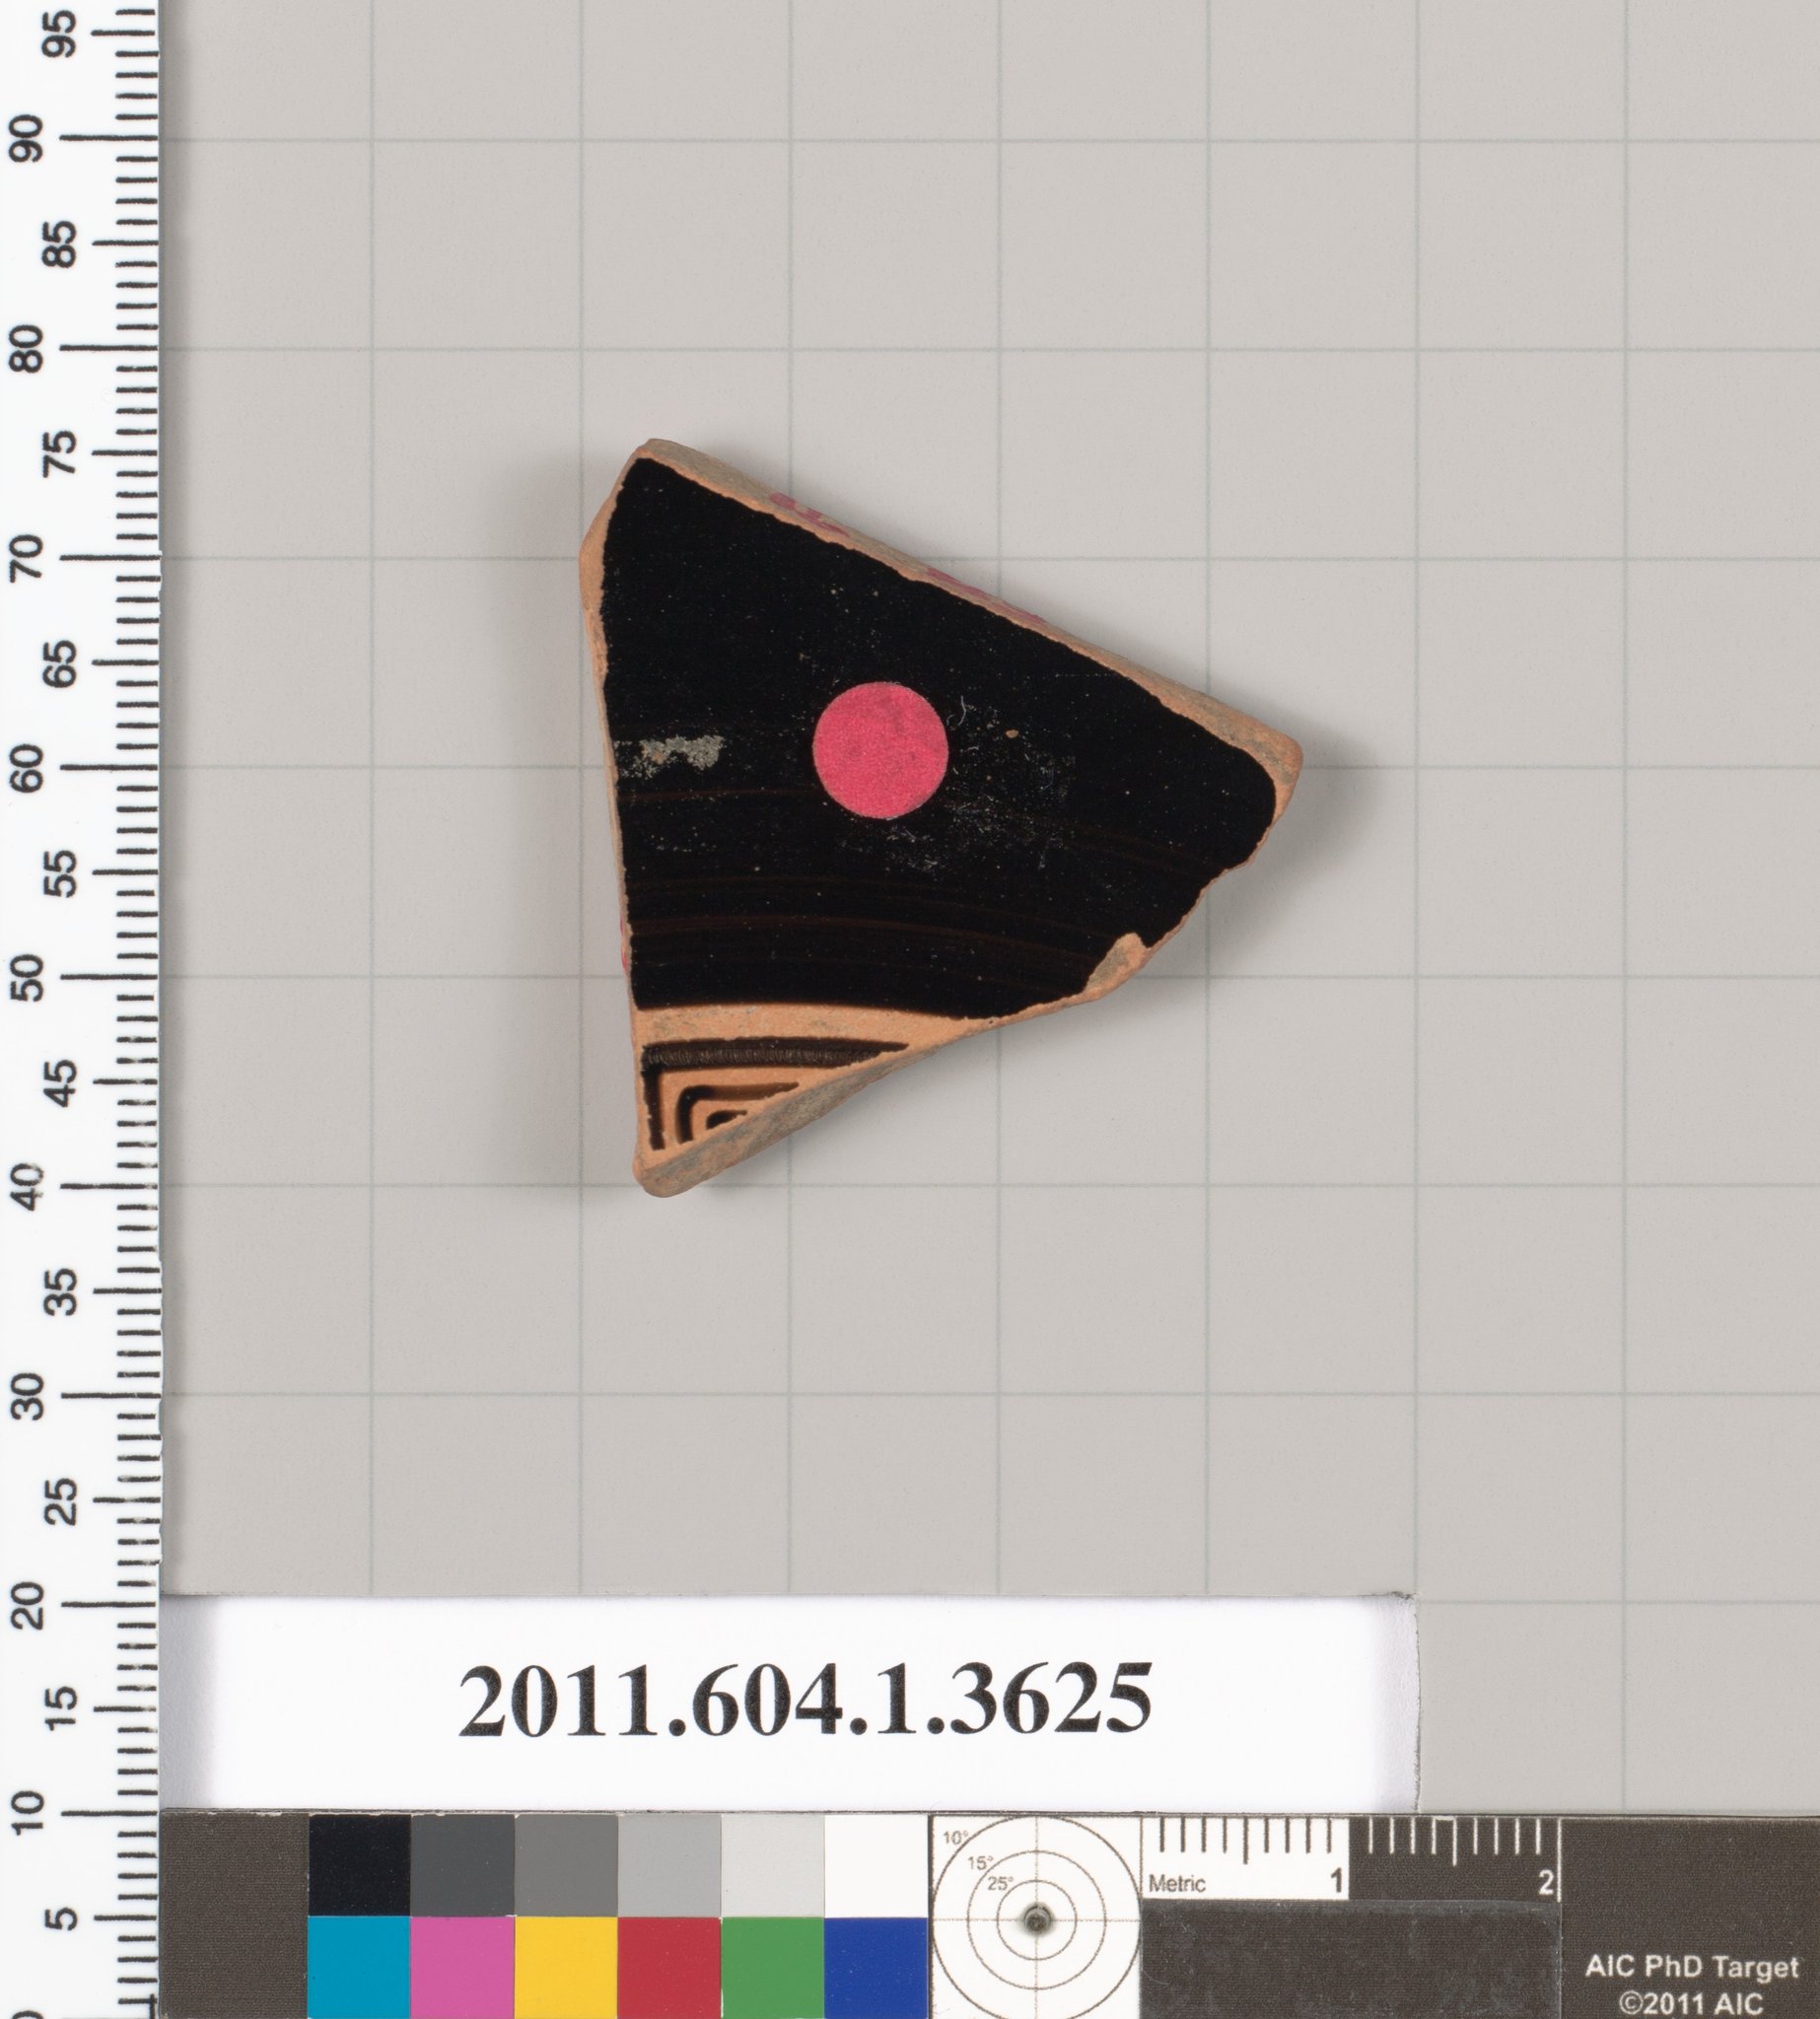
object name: kylix fragment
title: Terracotta fragment of a kylix (drinking cup)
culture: greek, attic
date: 475-451 BCE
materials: terracotta